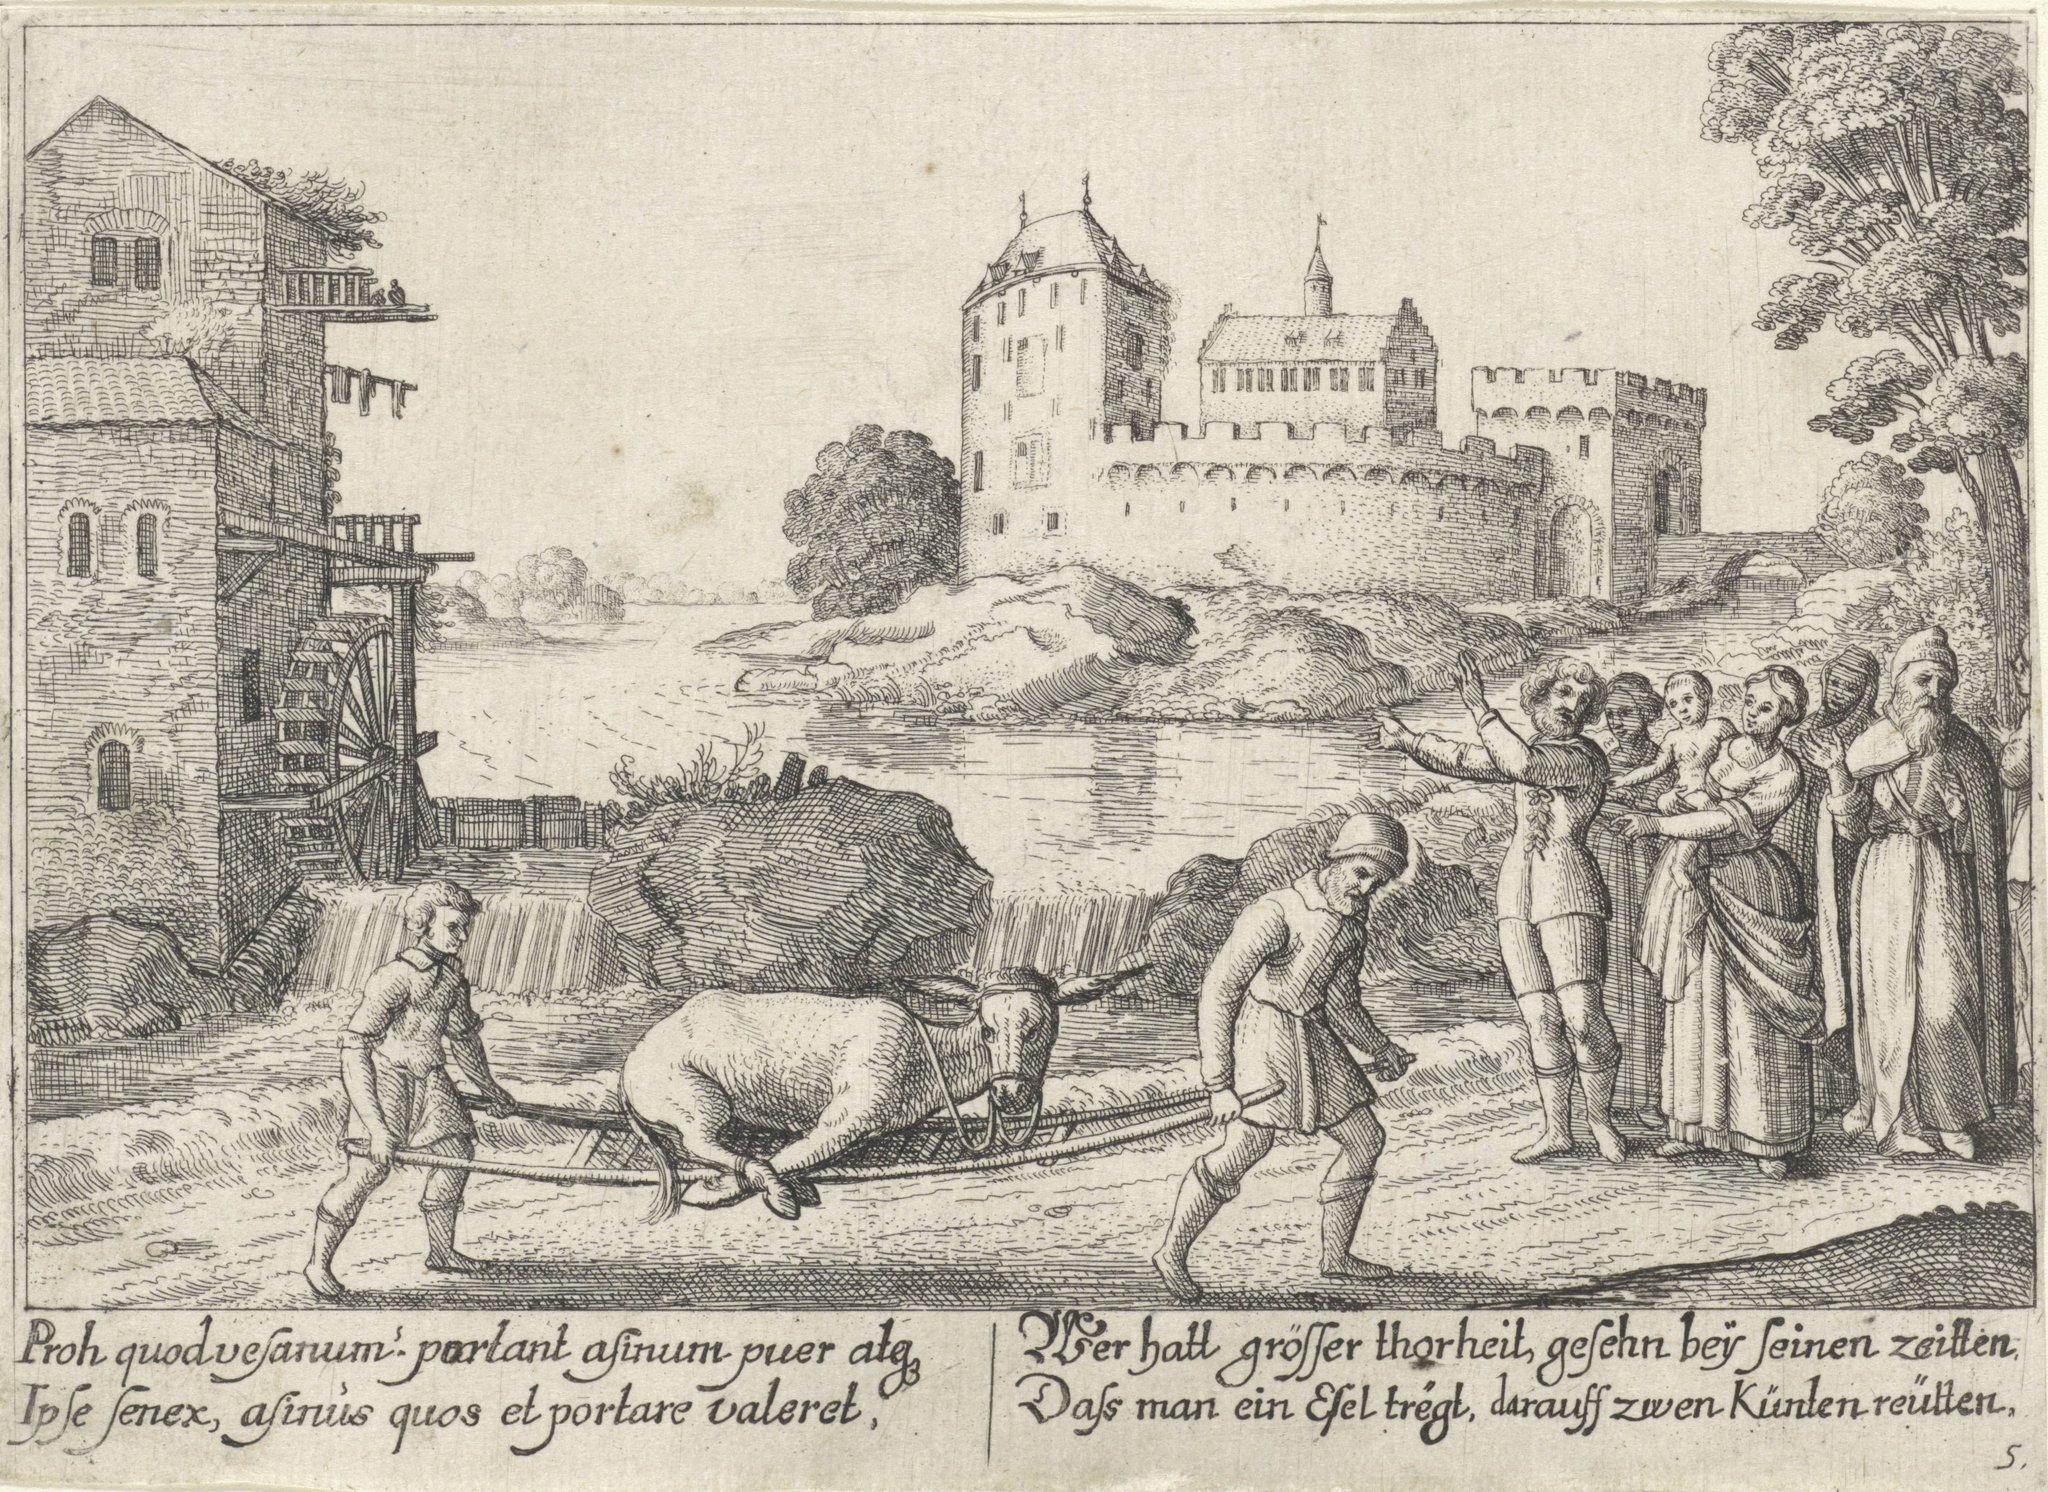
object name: print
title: Fabel van de boer en zijn ezel; De boer en zijn zoon dragen de ezel op een draagbaar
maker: wenceslaus hollar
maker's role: draughtsman, print maker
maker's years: 1607-1677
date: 1627-1628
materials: paper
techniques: etching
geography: germany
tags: ass, donkey, fables of aesop : use 85(...)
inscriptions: collector's mark: Lugt 2228